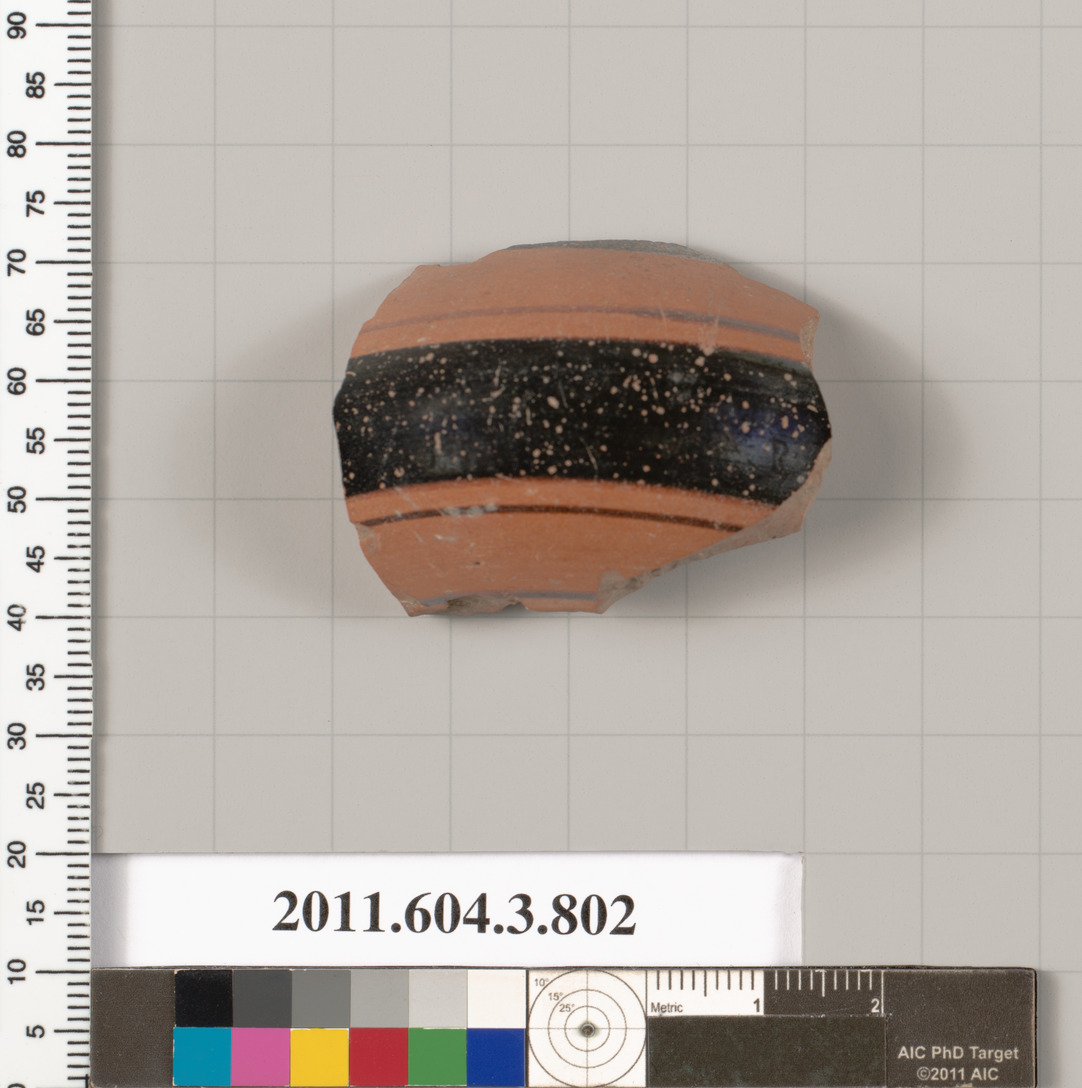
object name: lydion fragment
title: Terracotta fragment of a lydion (perfume jar)?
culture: greek, attic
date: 600-501 BCE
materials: terracotta